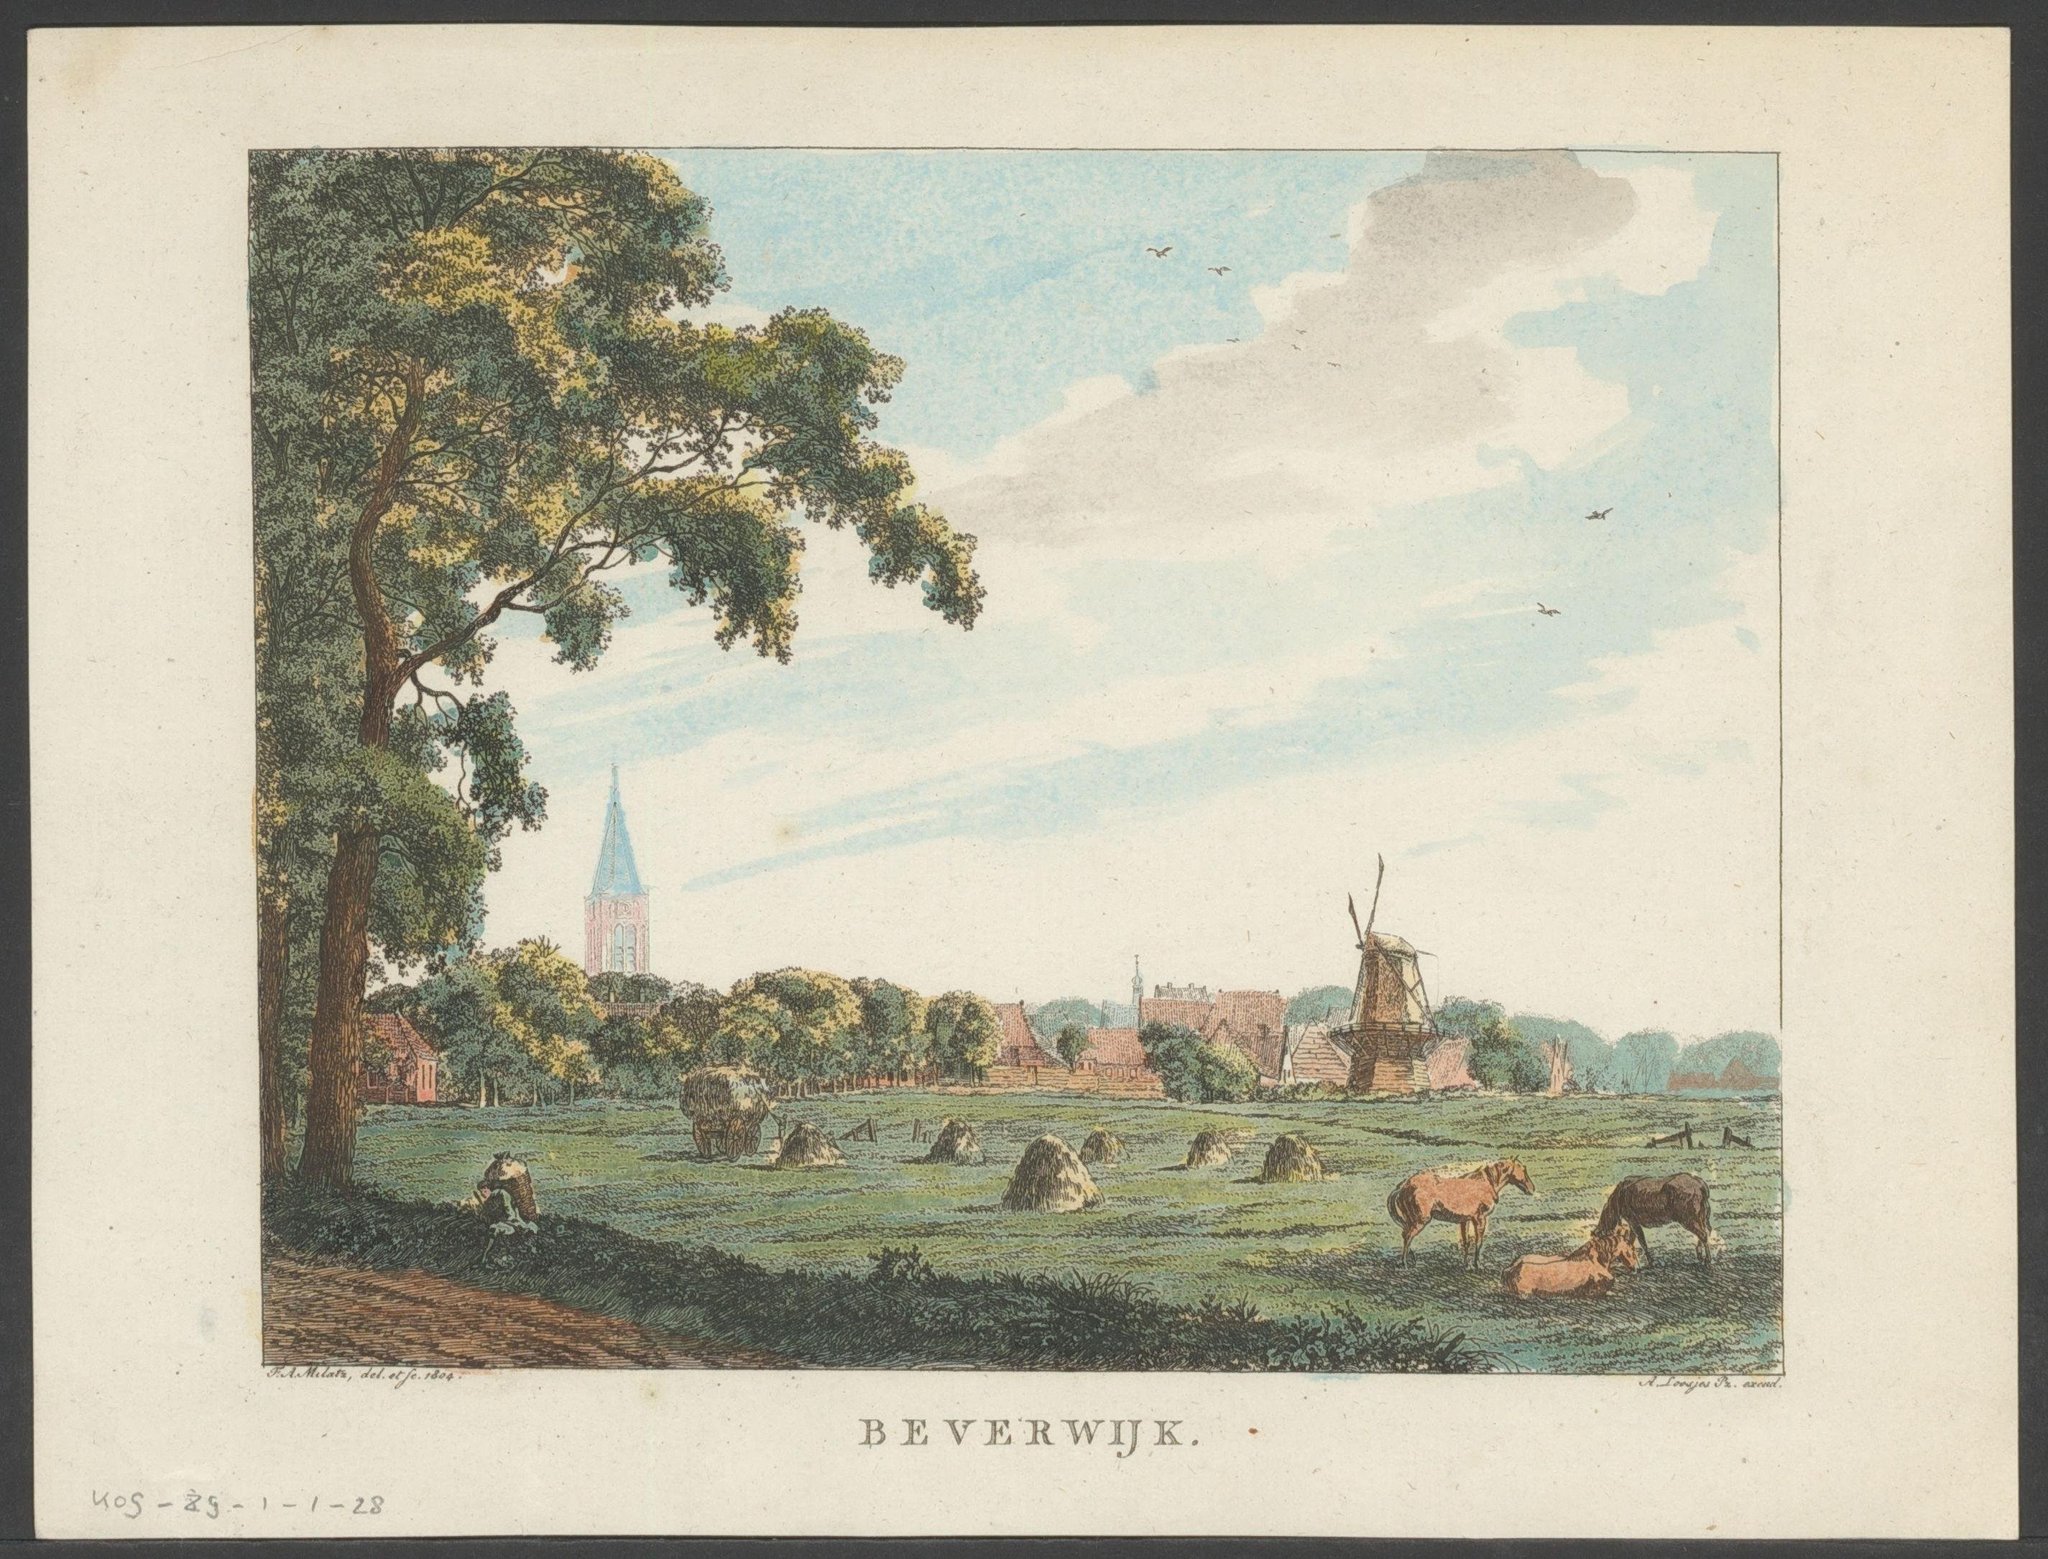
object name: print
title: Gezicht op Beverwijk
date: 1804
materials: paper, watercolor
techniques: etching, hand coloring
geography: netherlands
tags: prospect of village, silhouette of village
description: Gezicht op de plaats Beverwijk. Op de voorgrond een weiland met paarden. Onderwerpsrubrieken binnen de Atlas Zeden en Gewoonten: topografie; stadsprofielen.